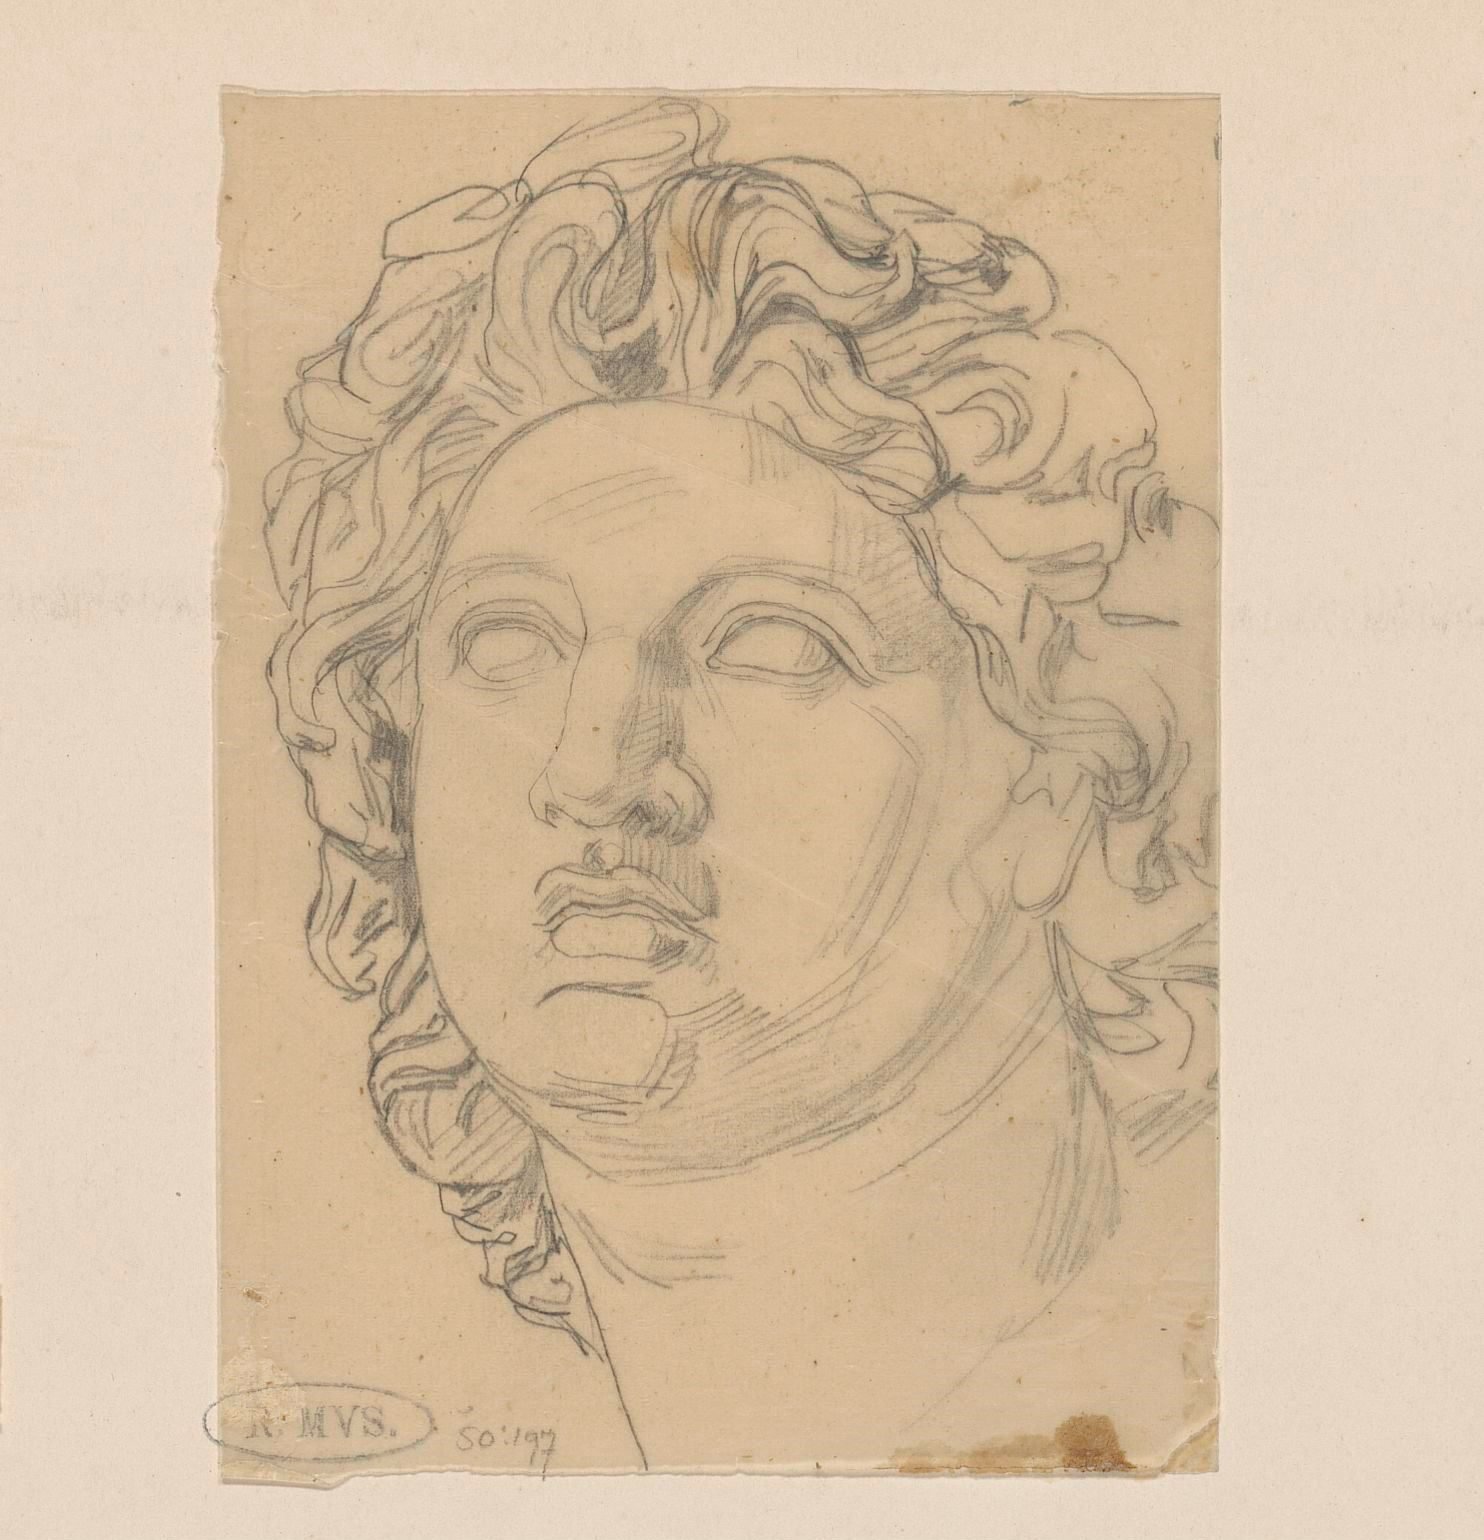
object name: drawing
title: Mannenkop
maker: august allebé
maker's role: draughtsman, print maker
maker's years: 1838-1927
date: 1848-1927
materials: pencil, paper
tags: head (human), piece of sculpture, reproduction of a piece of sculpture